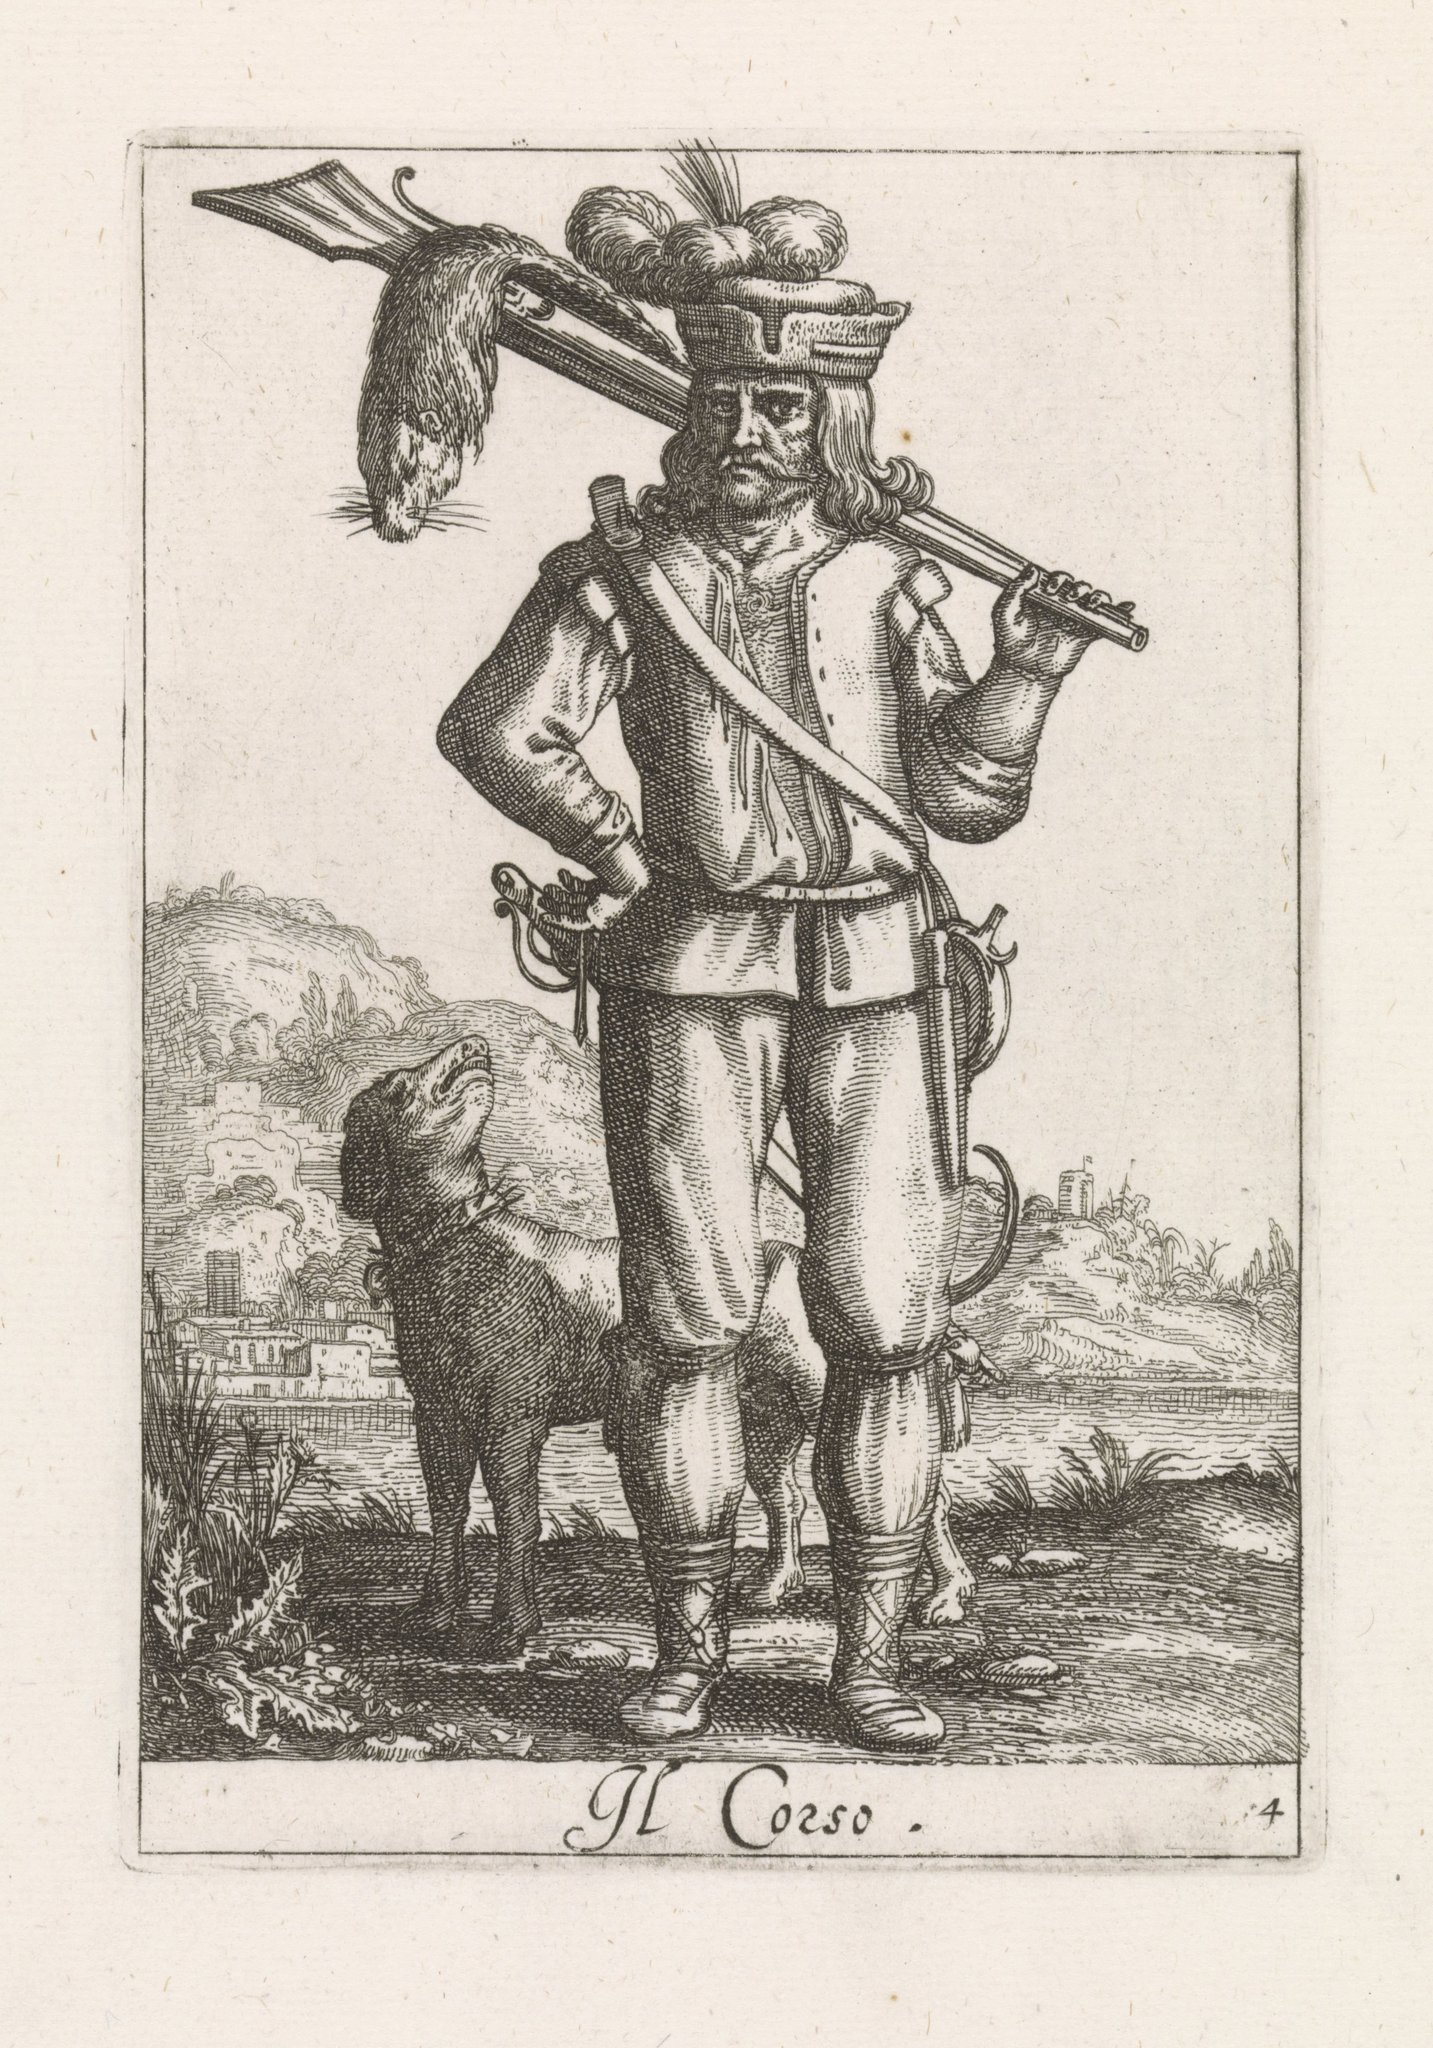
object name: print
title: Kostuums uit Italië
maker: Anonymous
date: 1720-1772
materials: paper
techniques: etching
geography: amsterdam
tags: europeans (with name) (+ costume)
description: Landschap met man, gekleed in mode uit Corsica, Italië. De man is van voren en ten voeten uit weergegeven, achter hem staat een hond. Op zijn schouder rust een geweer waaraan een geschoten dier hangt, zijn hoofd is getooid met een gepluimde hoed. De prent maakt deel uit van een twaalfdelige serie prenten met Italiaanse kostuums.